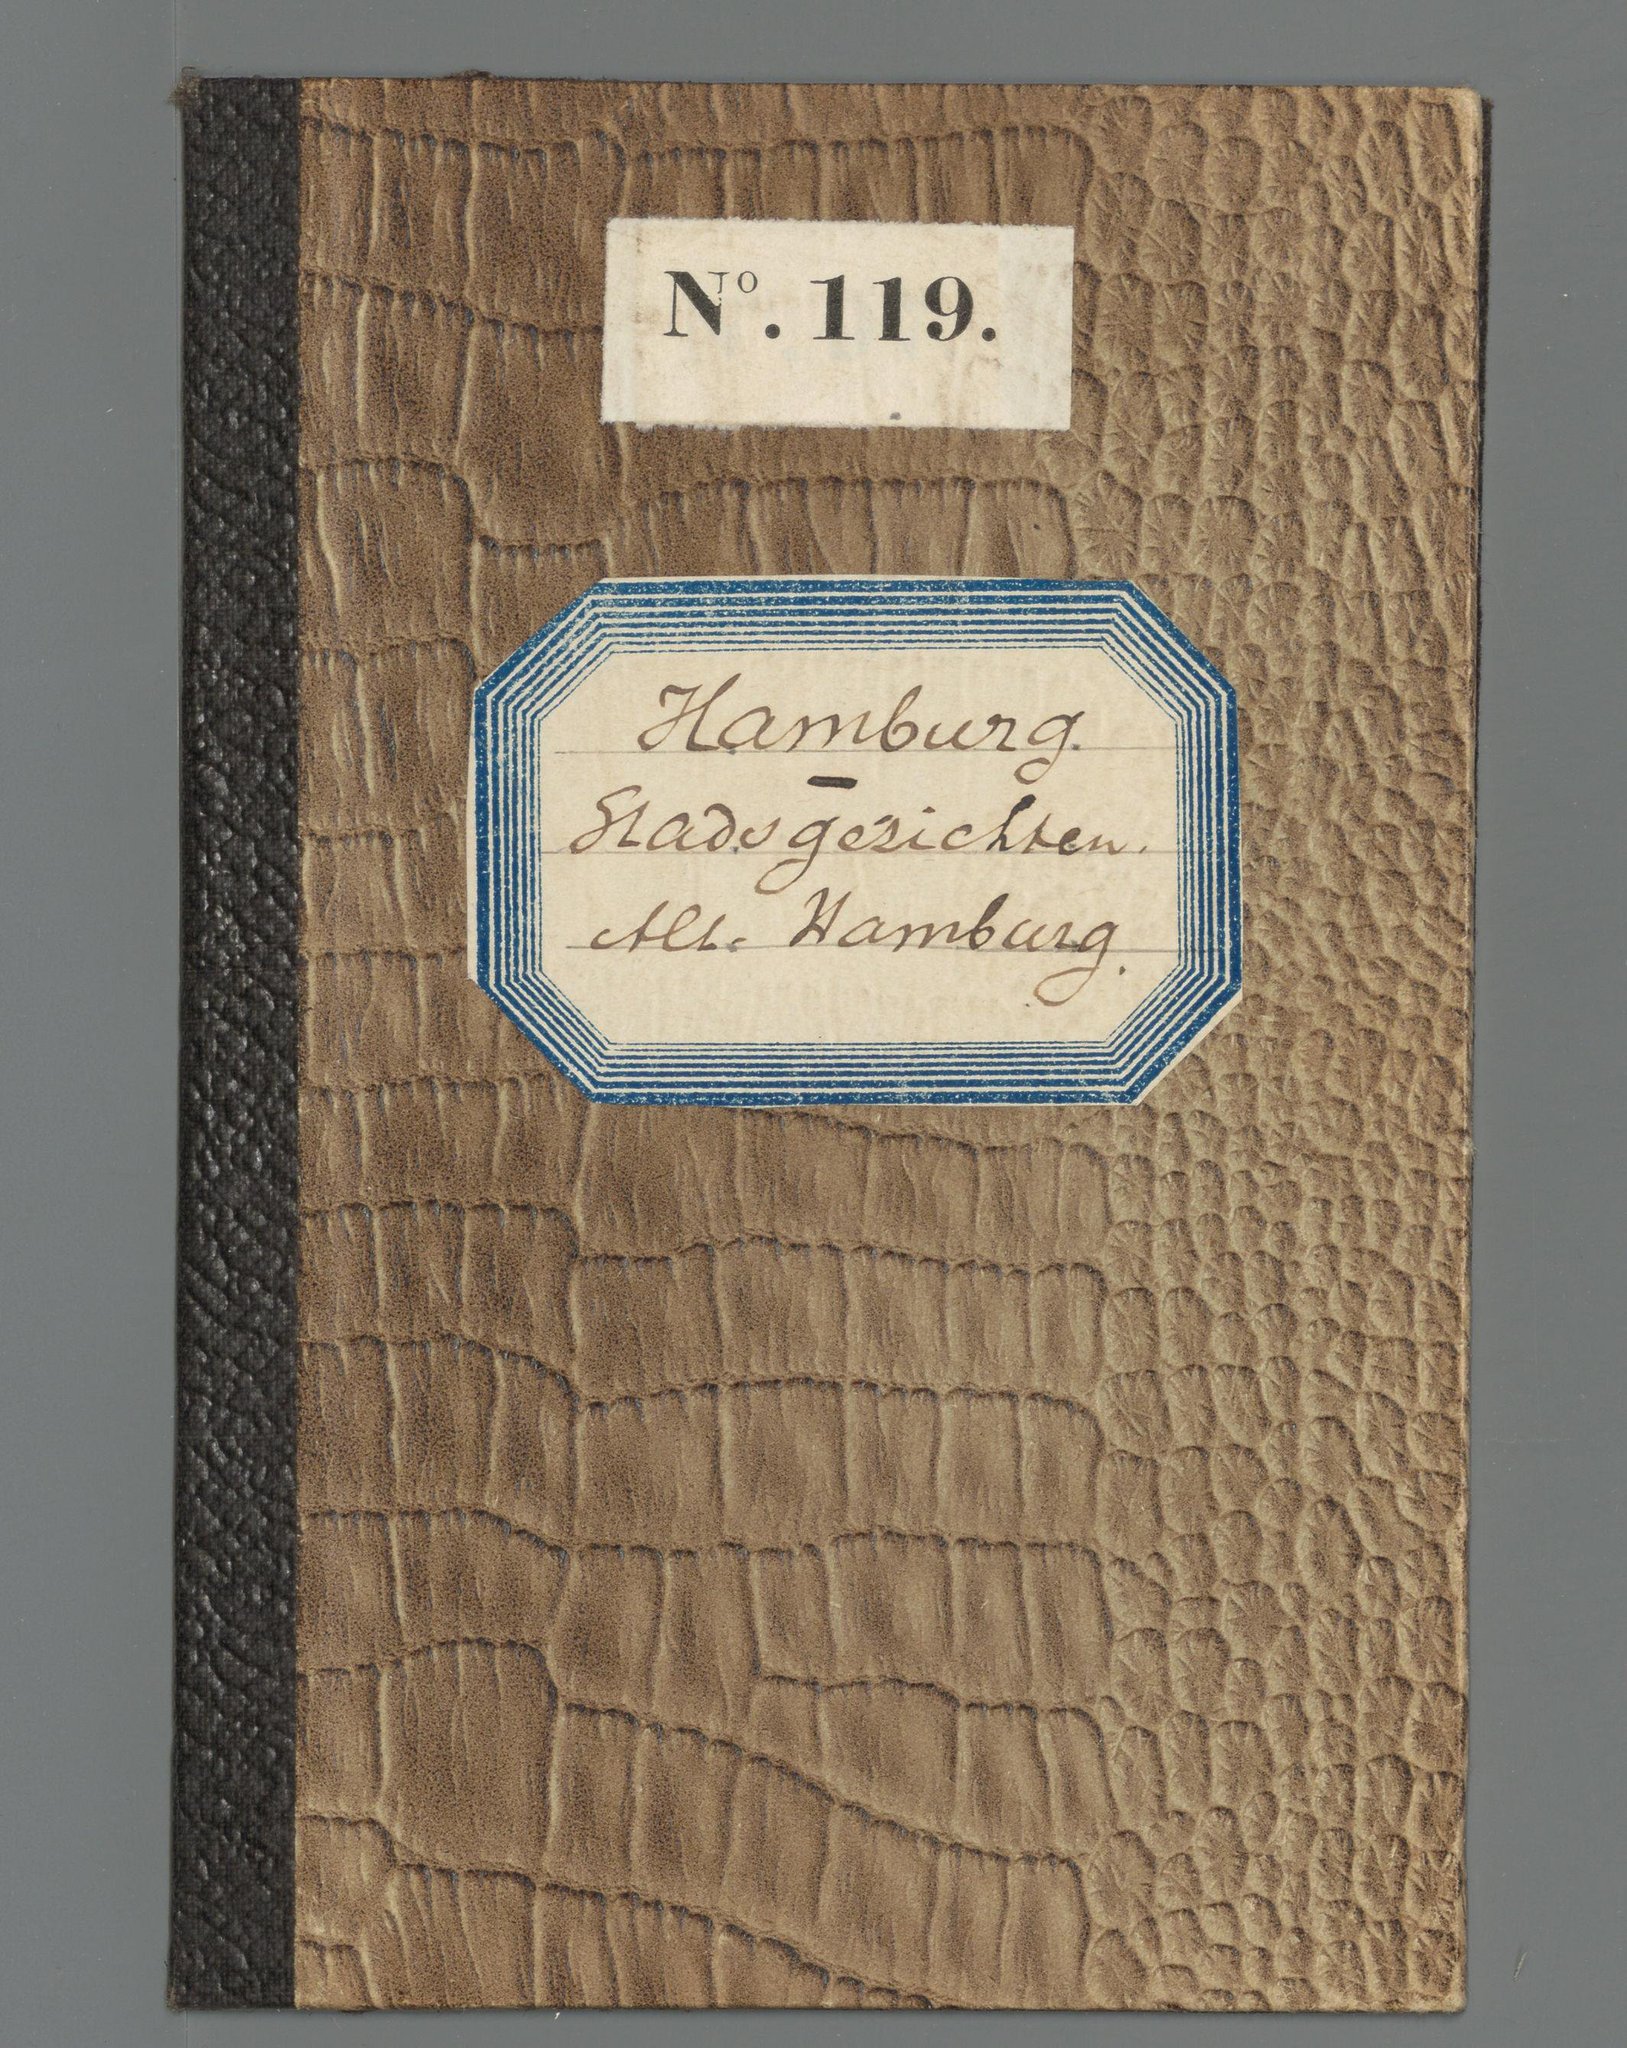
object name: wrapper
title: Omslag voor 44 prentbriefkaarten met stadsgezichten uit Hamburg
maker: Anonymous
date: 1900-1950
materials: cardboard, paper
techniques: lithograph, writing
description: In de omslag zit een kaart ingestoken met daarop een korte beschrijving van de inhoud.